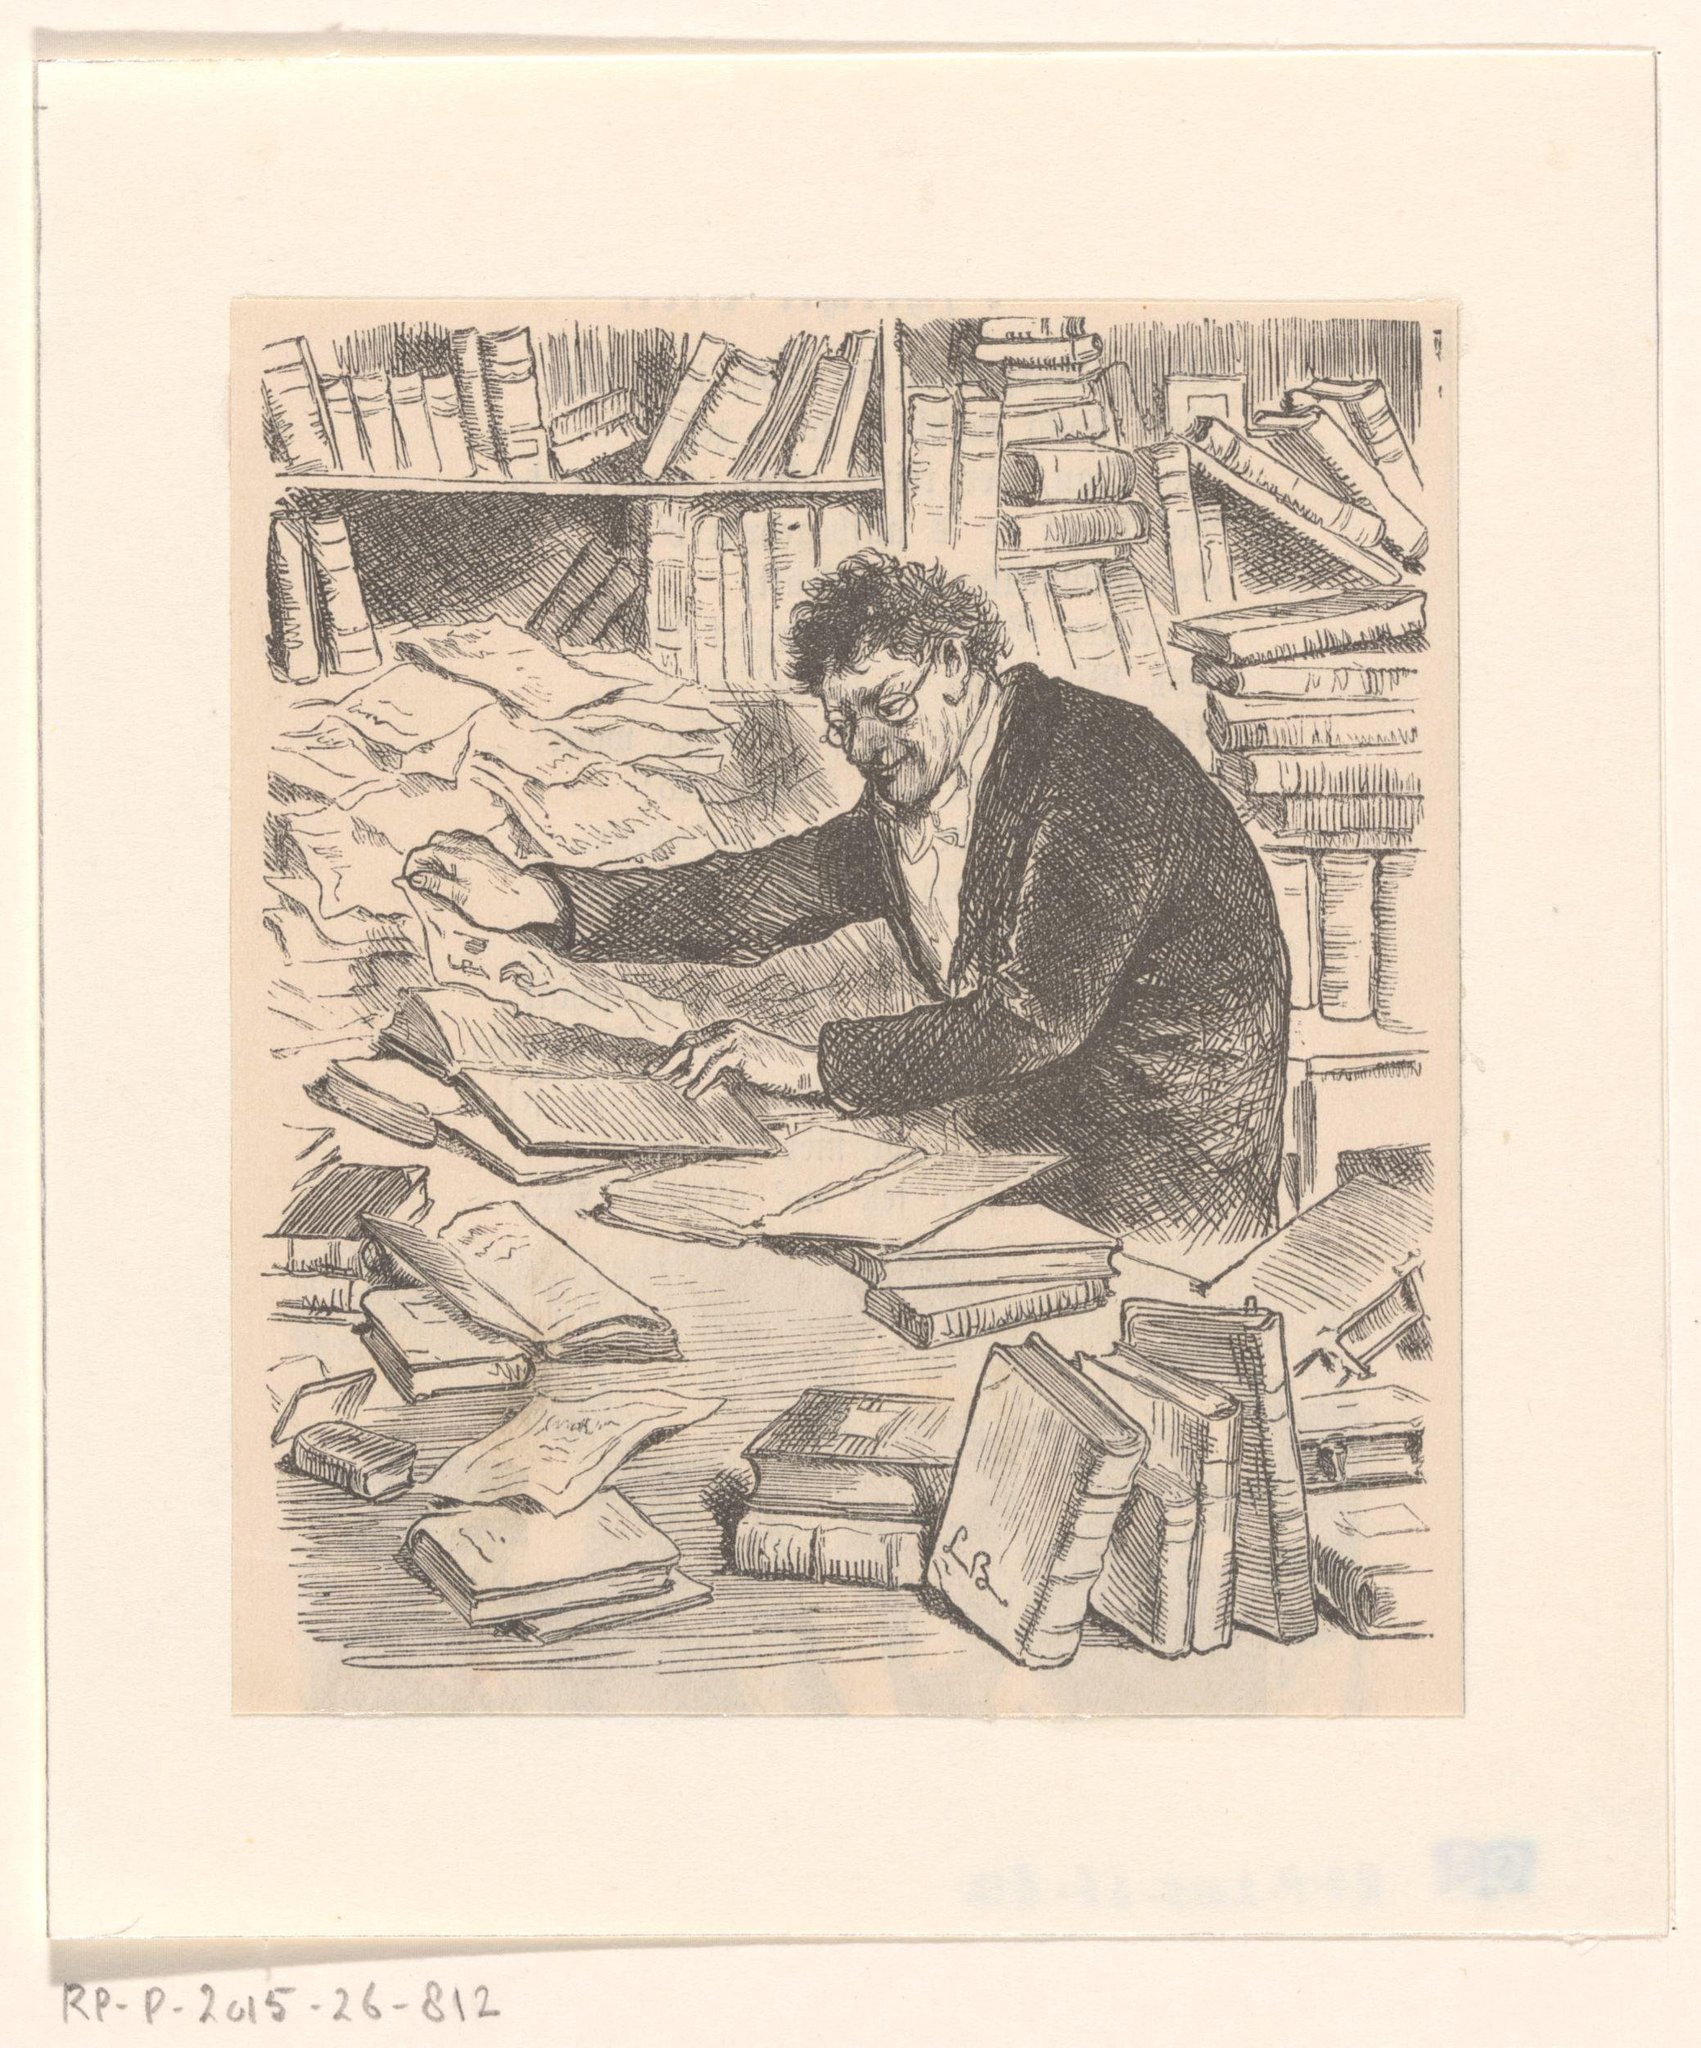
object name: print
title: Lezende man in een interieur vol boeken en papieren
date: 1850-1900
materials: paper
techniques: lithograph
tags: book, newspaper, news-sheet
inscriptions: collector's mark: Lugt 2228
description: Waarschijnlijk een illustratie uit een boek of tijdschrift.